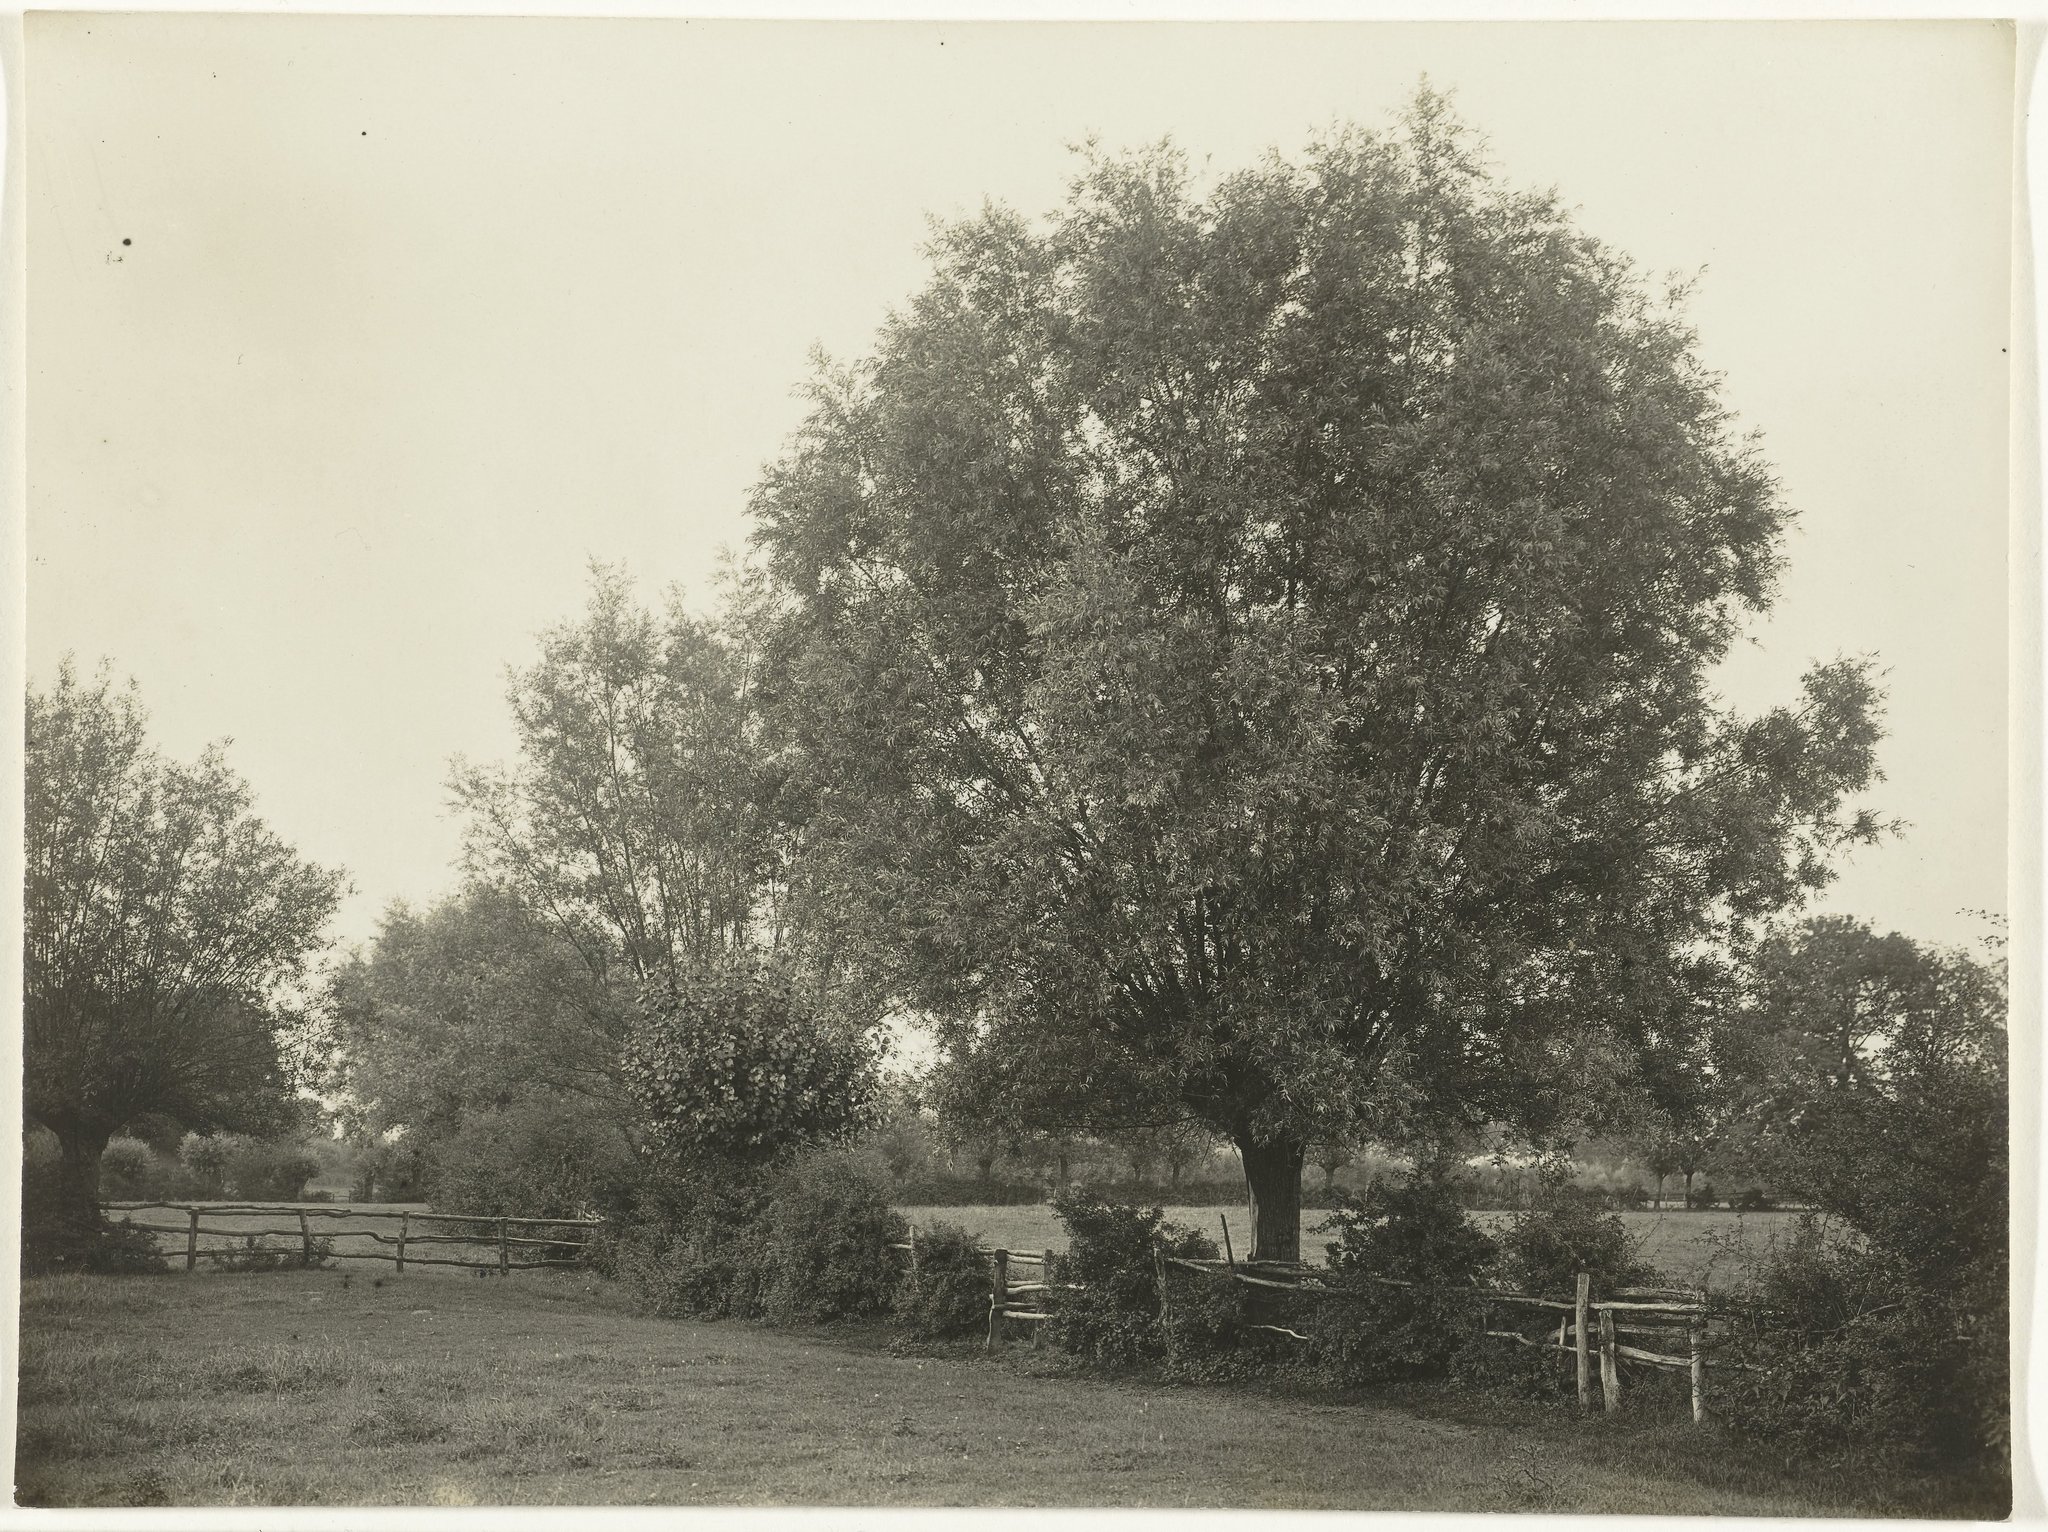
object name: photograph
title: Knootwilgen in zomertooi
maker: richard tepe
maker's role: fotograaf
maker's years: 1864-1952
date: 1900-1930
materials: paper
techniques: gelatin silver print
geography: netherlands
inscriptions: signature: ‘foto / R Tepe’, signature: ‘Knootwilgen [sic] / in zomertooi’